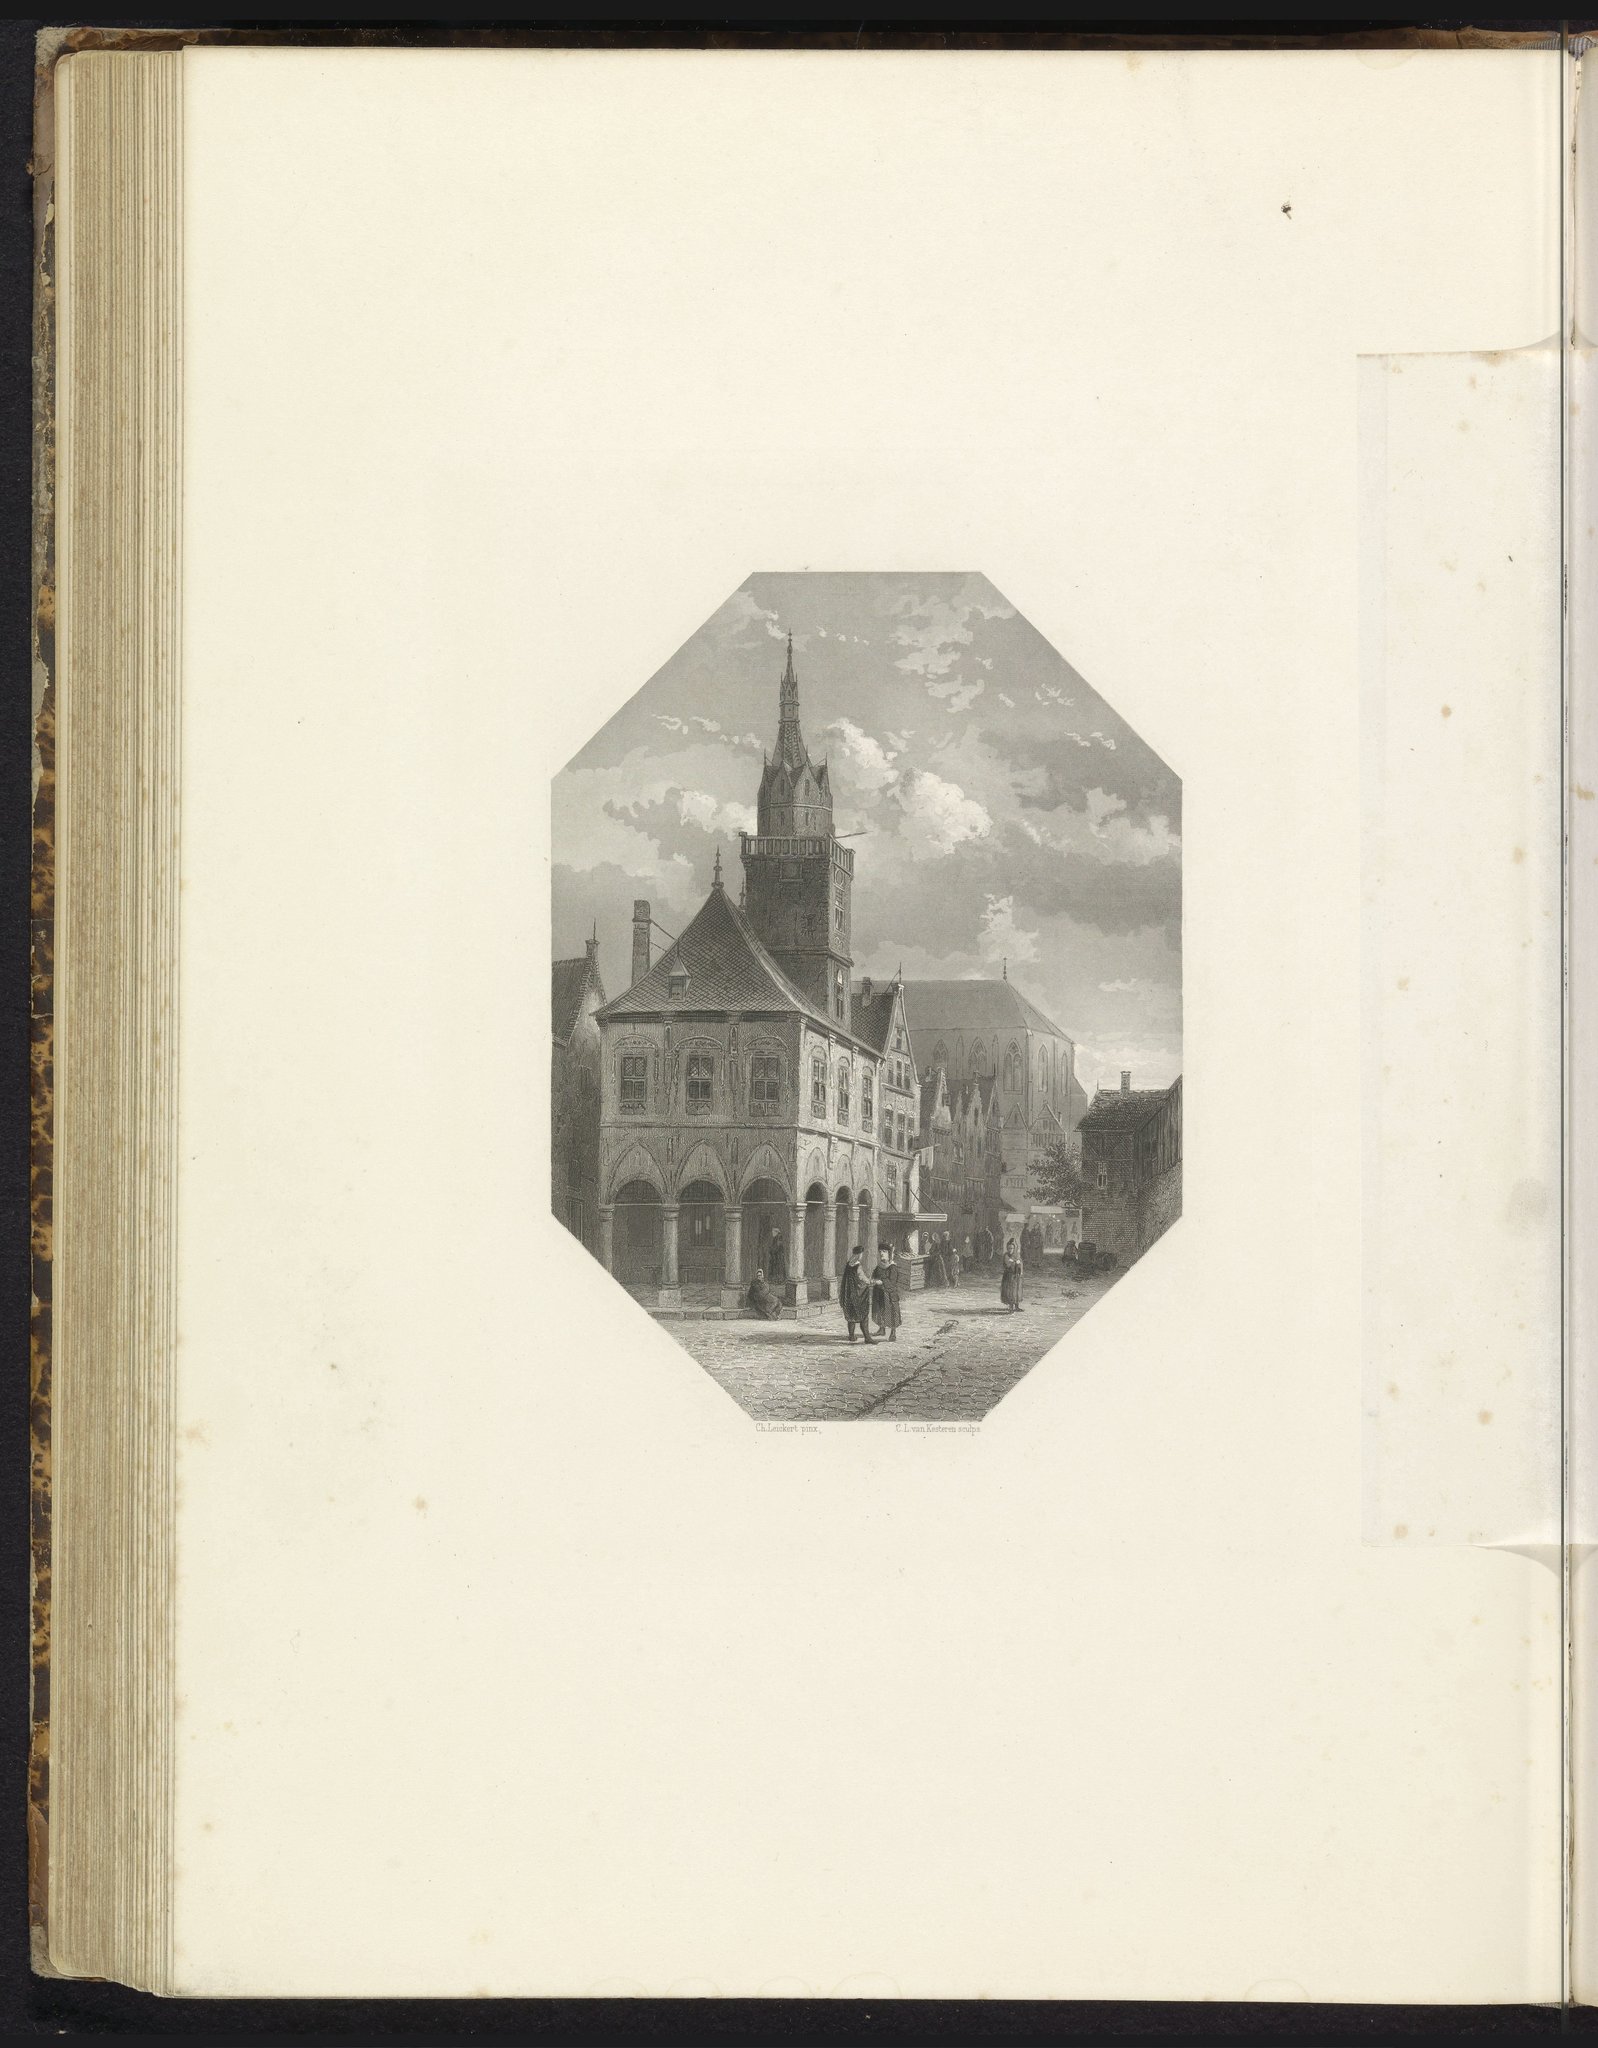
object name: print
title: Oude Stadhuis van Amsterdam, ca. 1450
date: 1865-1870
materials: paper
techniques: engraving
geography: netherlands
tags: burgundian netherlands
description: Gezicht op het Oude Stadhuis van Amsterdam, ca. 1450. Onderdeel van de groep staalgravures naar de schilderijen van de Historische Galerij der Maatschappij Arti et Amicitiae.